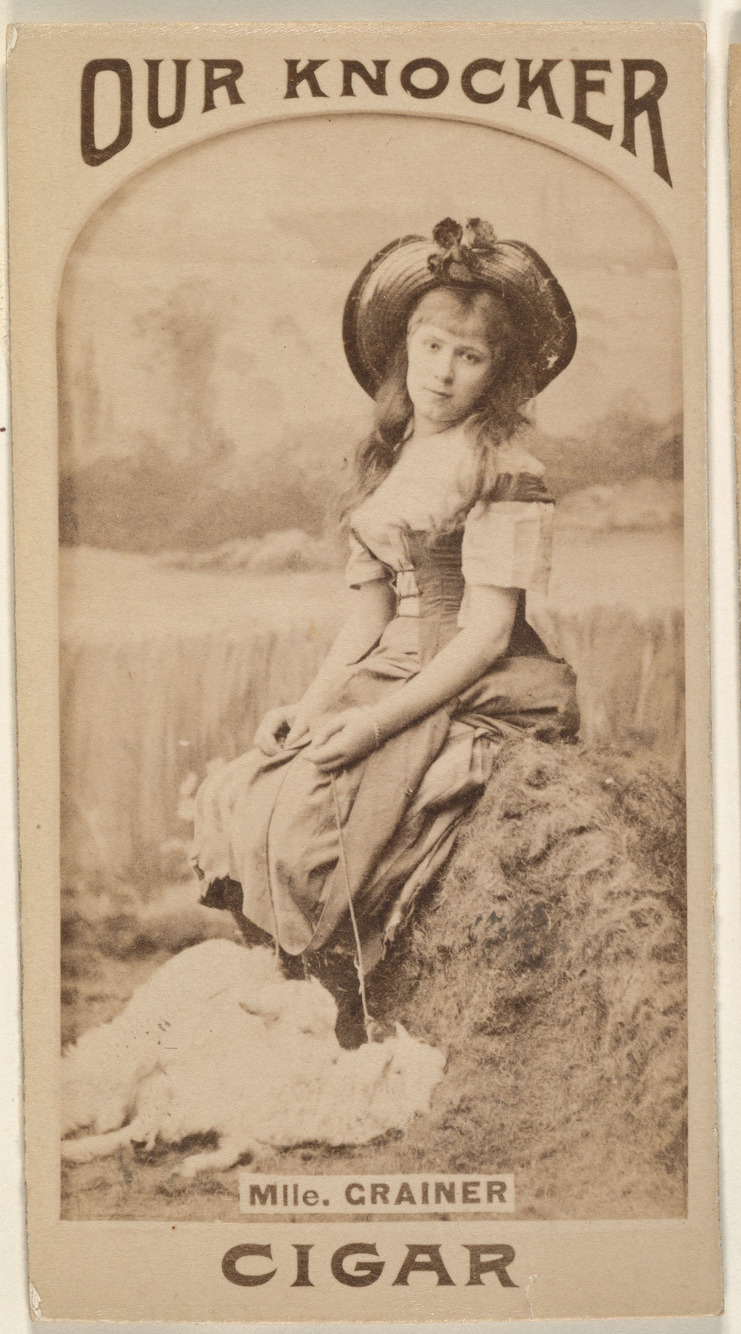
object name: photograph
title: Mlle. Grainer, from the Actresses series (N665) promoting Our Knocker Cigars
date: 1888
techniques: albumen silver print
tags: portraits,women,actresses